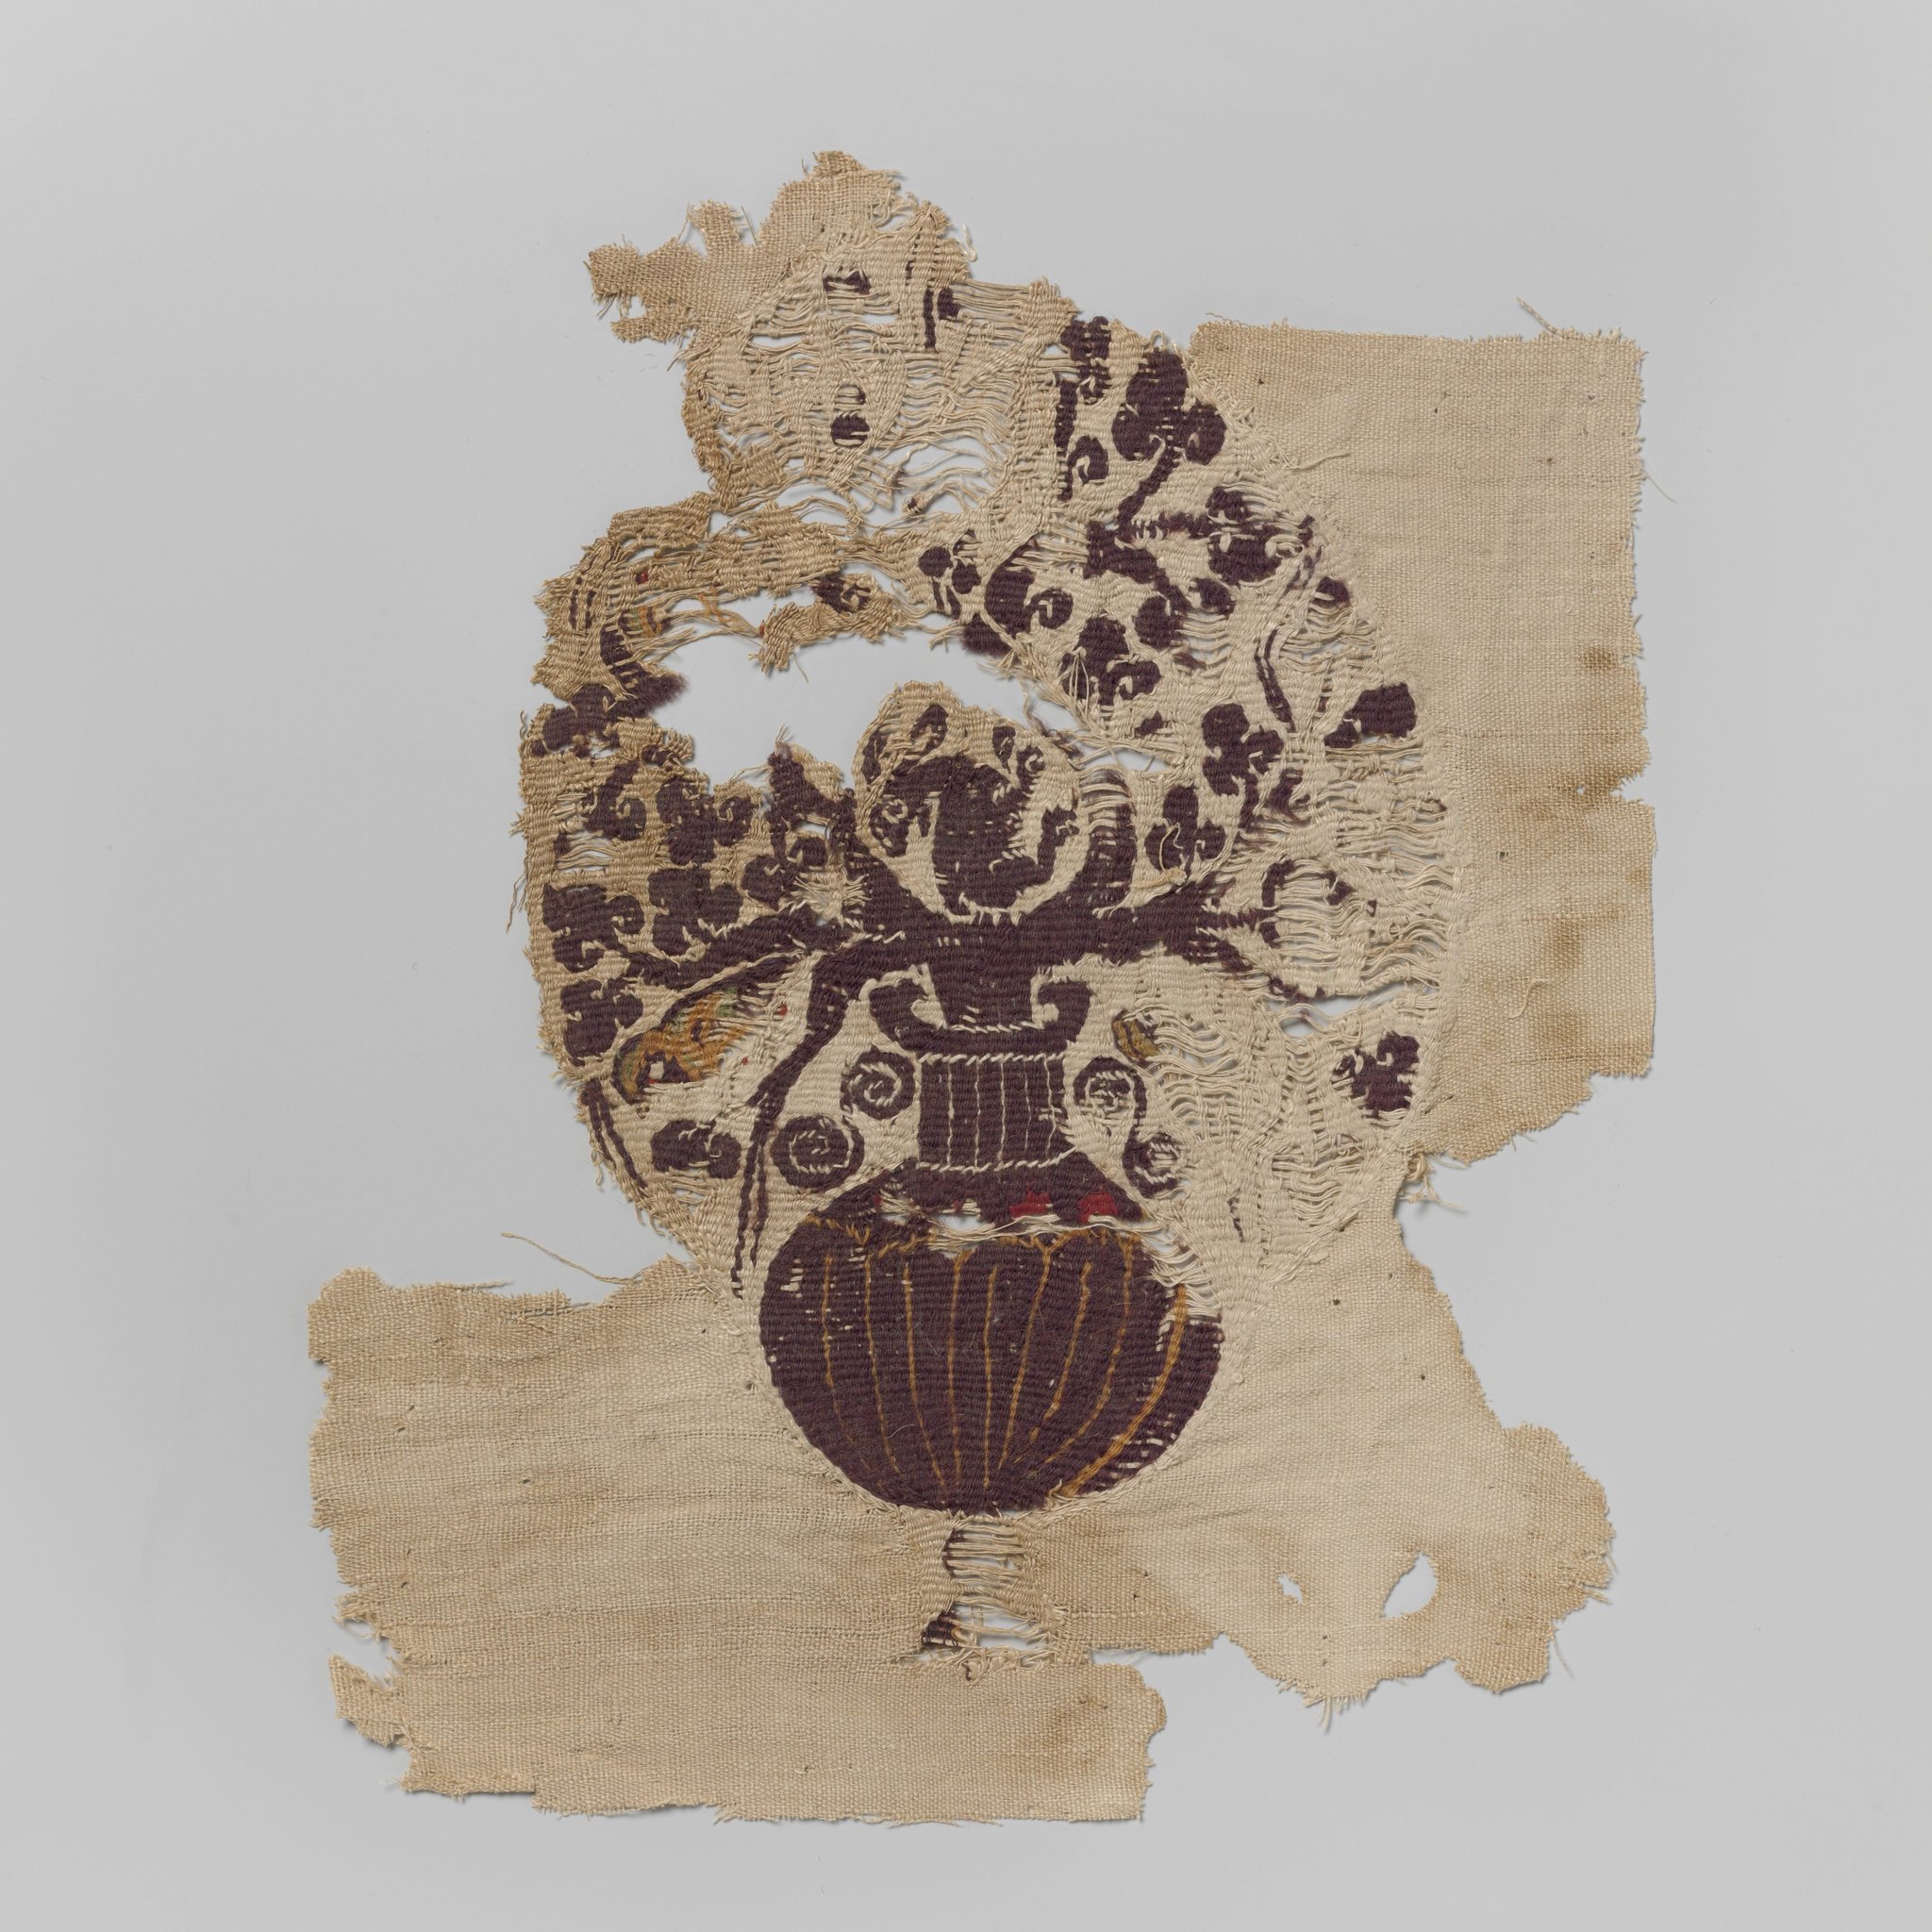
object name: fragment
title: Weefselfragment in tapijtwerk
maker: Anonymous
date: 300-599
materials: linen, wool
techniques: weave, tapestry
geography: egypt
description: Naturelkleurig linnen weefselfragment met ingeweven ovaal motief met een vaas in purper, waaruit bladranken komen met centraal een omkijkende haas. Linksonder en elders fragmenten van vogels in oranje, groen en rood.